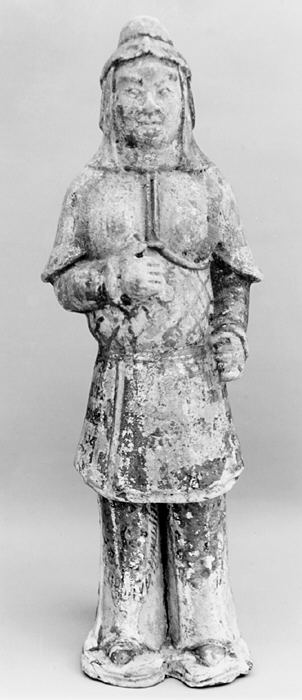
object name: figure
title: Warrior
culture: chinese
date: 601-800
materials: earthenware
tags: men,warriors